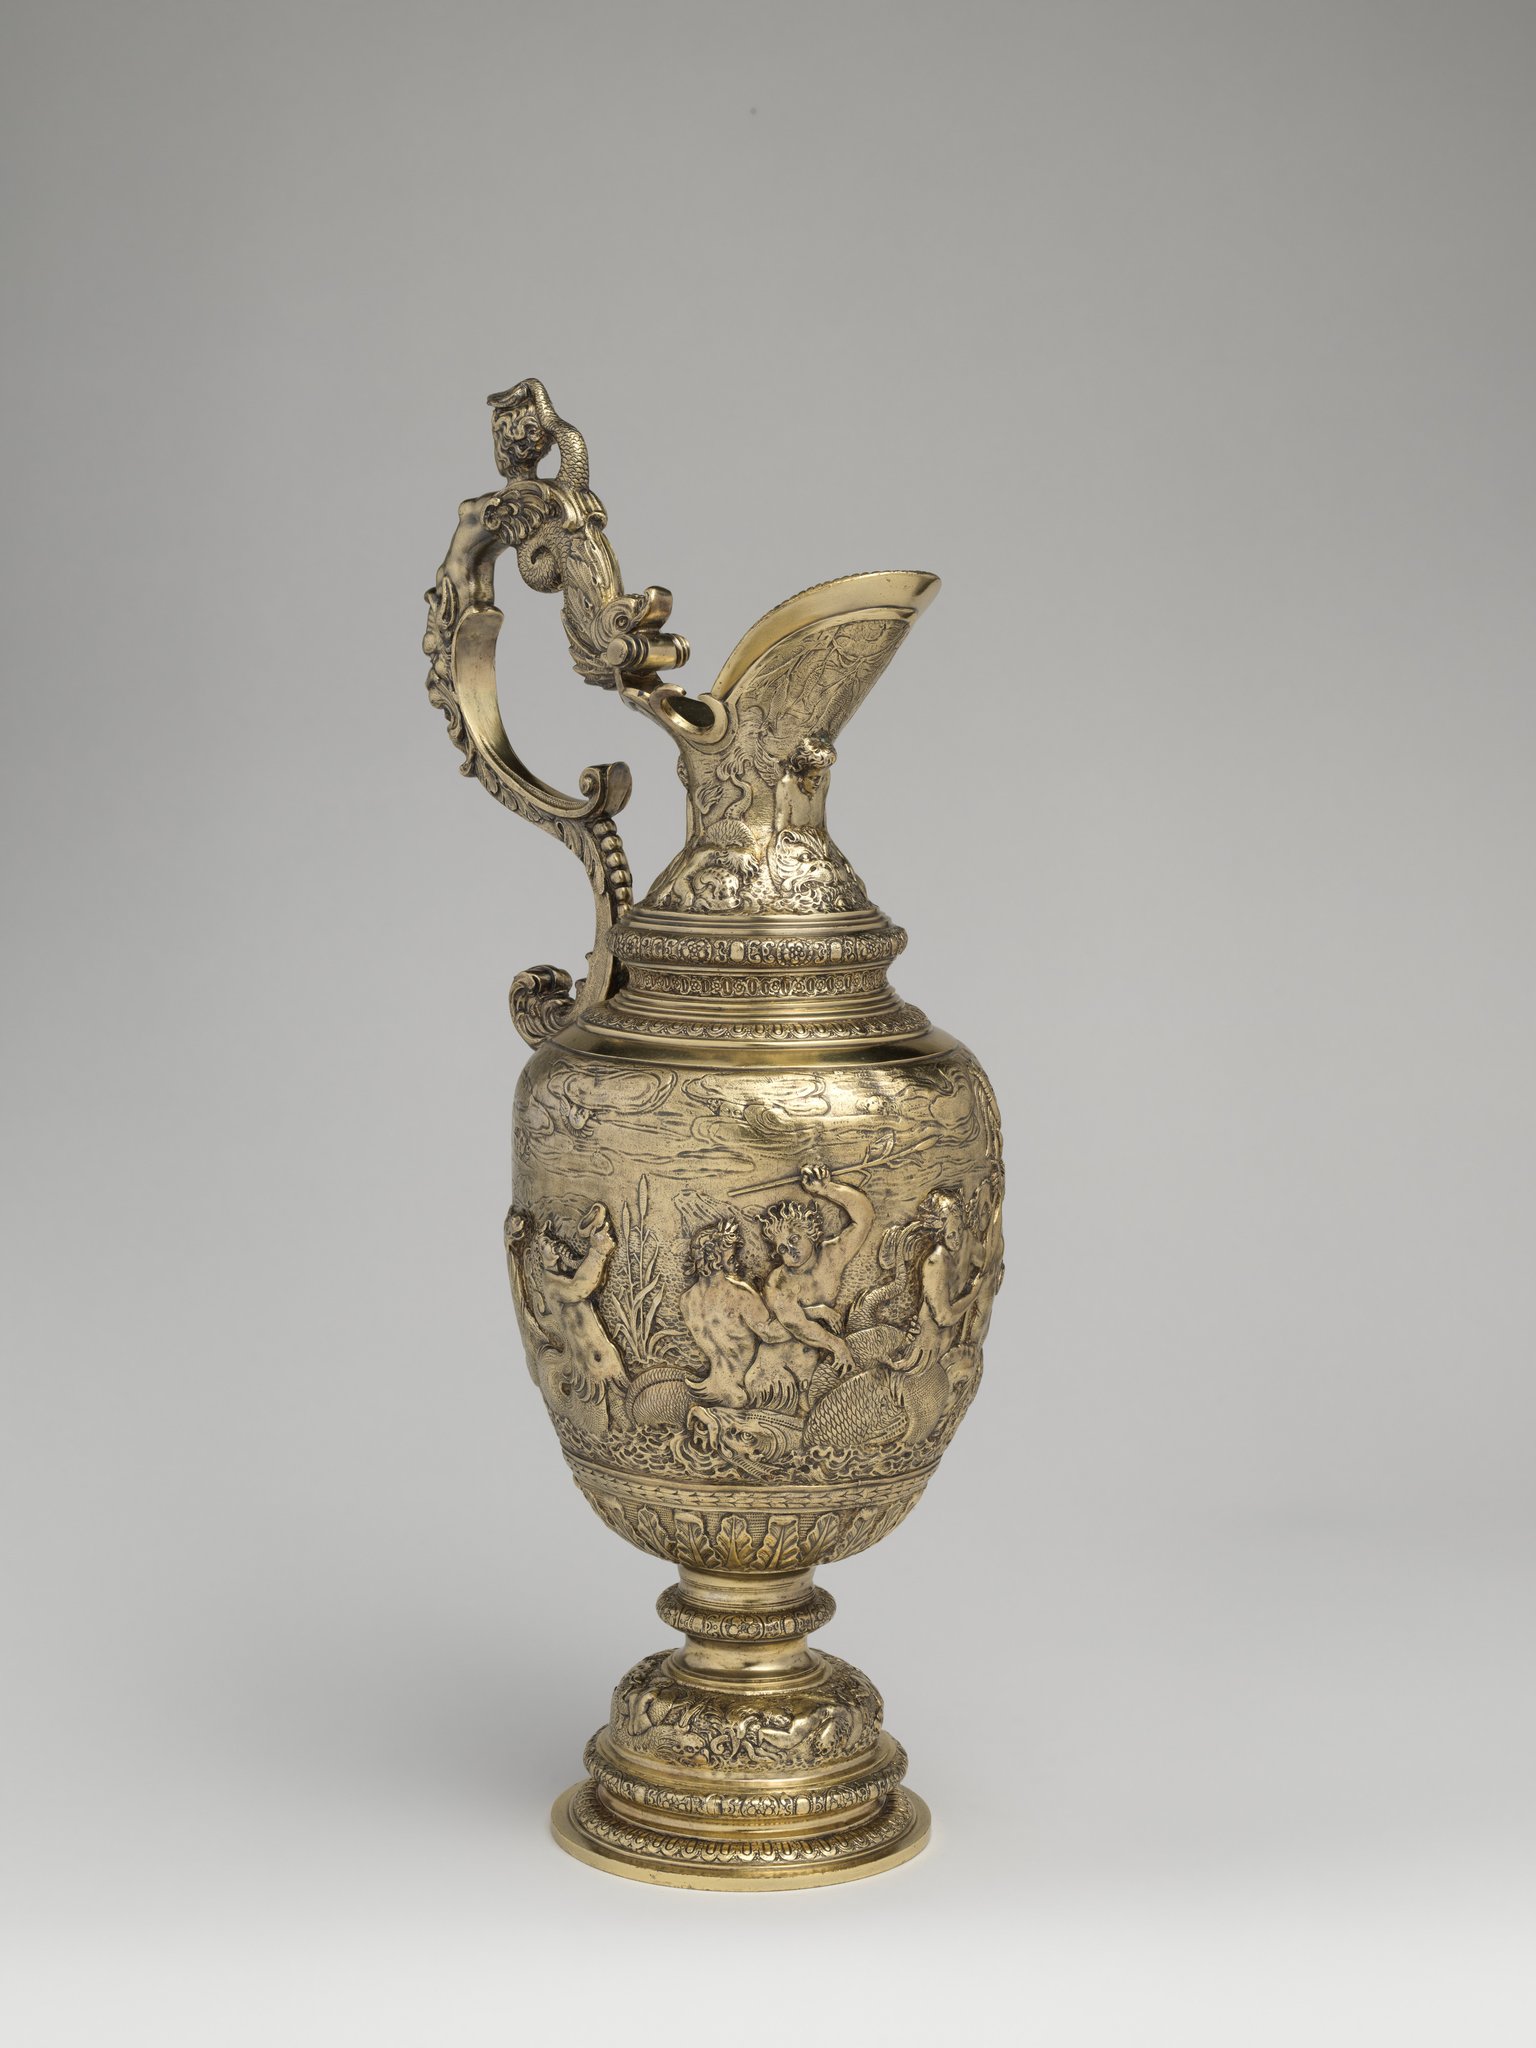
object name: ewer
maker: franchi and son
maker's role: manufacturer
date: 1801-1900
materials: metal, silver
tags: mythical creatures,dolphins